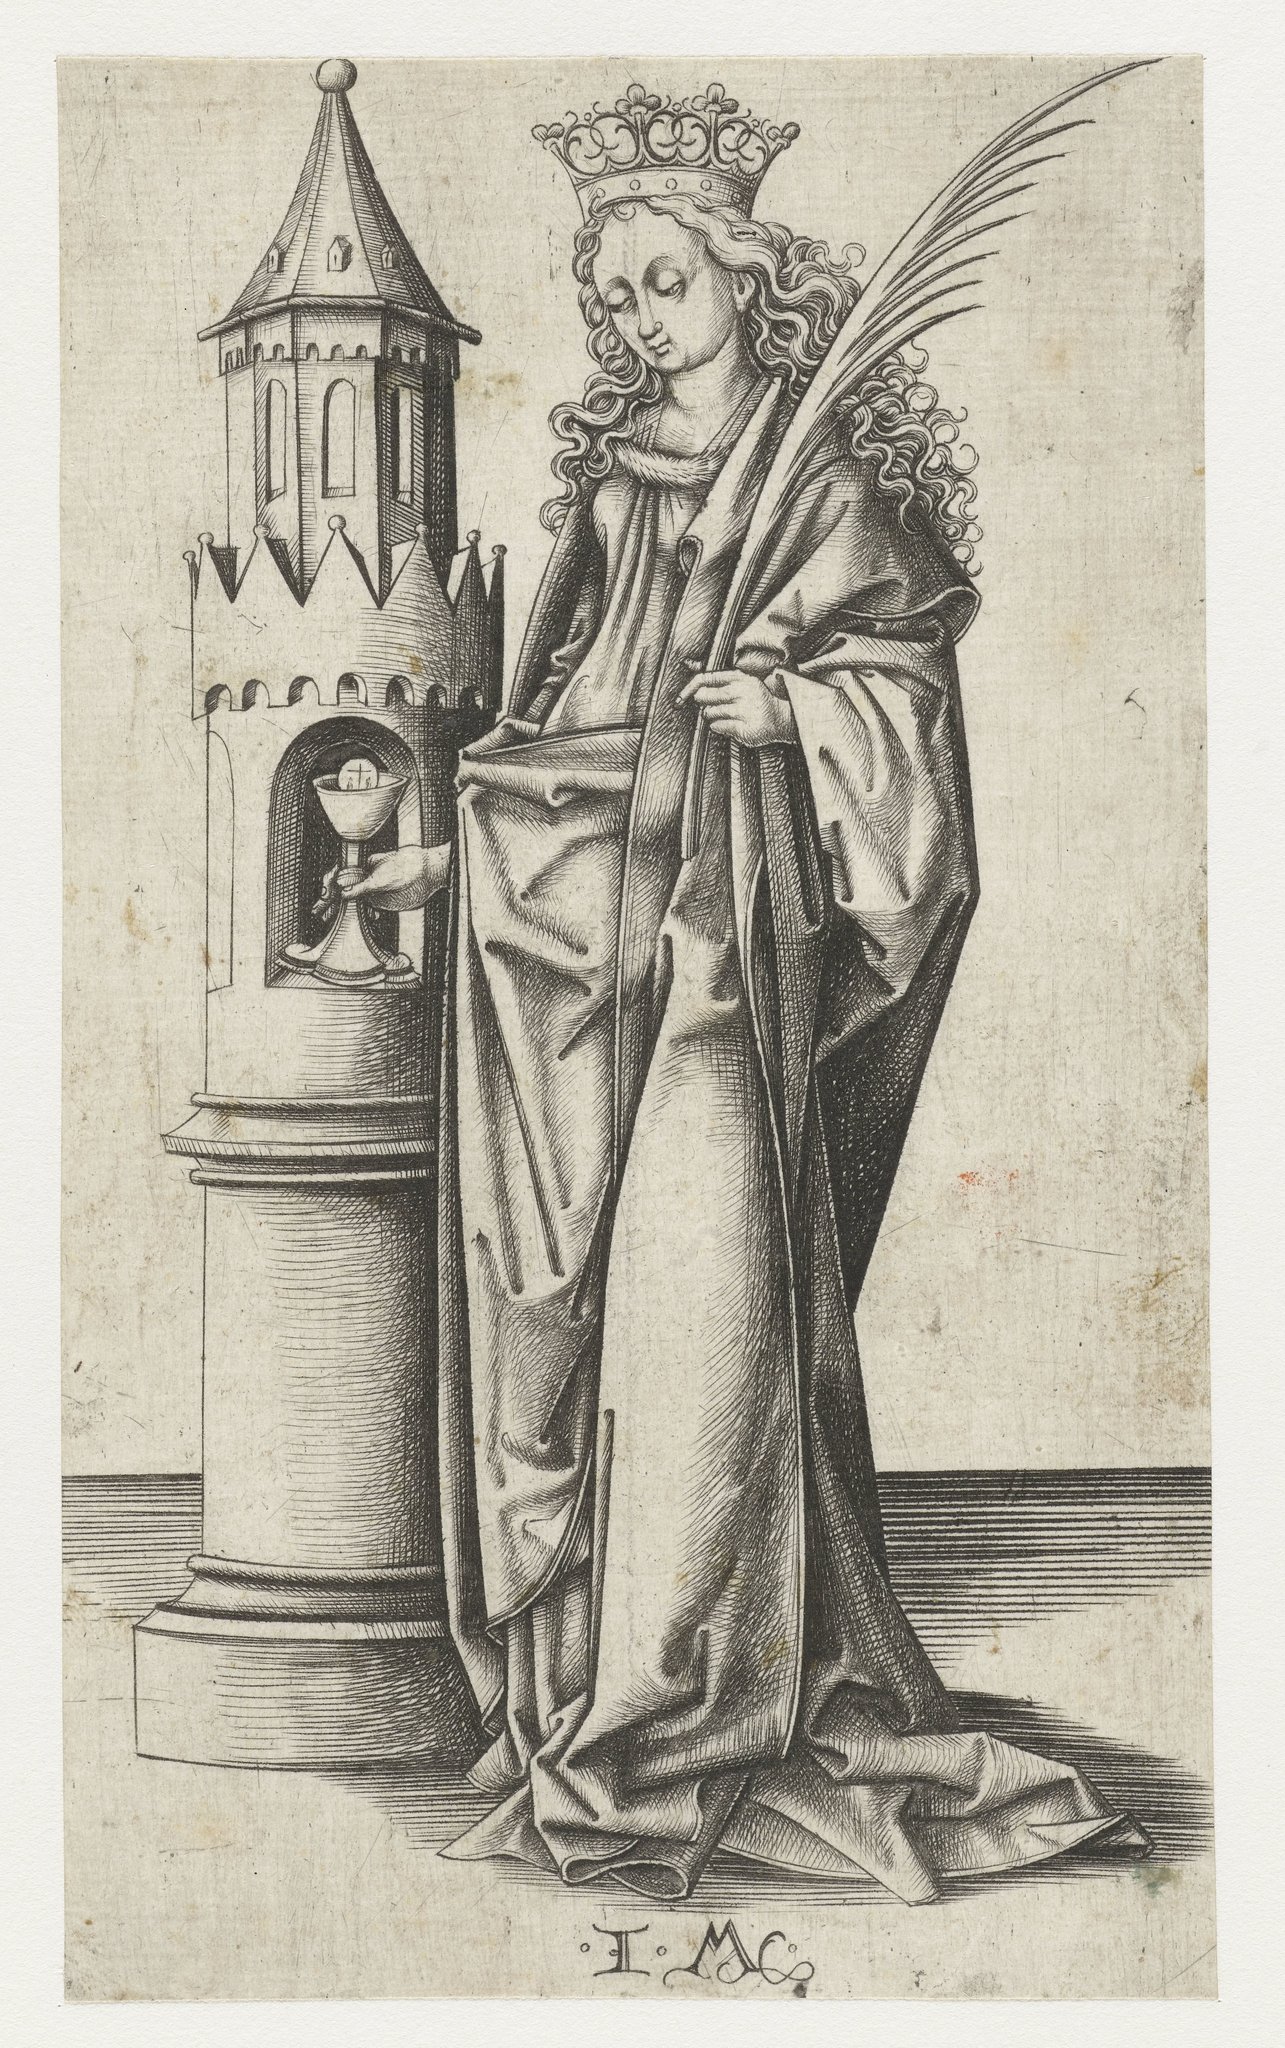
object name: print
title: Heilige Barbara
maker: israhel van meckenem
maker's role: print maker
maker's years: 1440-1517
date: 1455-1503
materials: paper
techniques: engraving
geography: bocholt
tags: the virgin martyr barbara; possible attributes: book, cannon(ball), crown, cross, chalice with wafer, dioscuros (her father), peacock feather, sword, torches, mason's tools, tower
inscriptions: collector's mark: Lugt 2228a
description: De Heilige Barbara staat naast een toren, een kelk met een hostie in de ene hand, een palmtak in de andere hand.